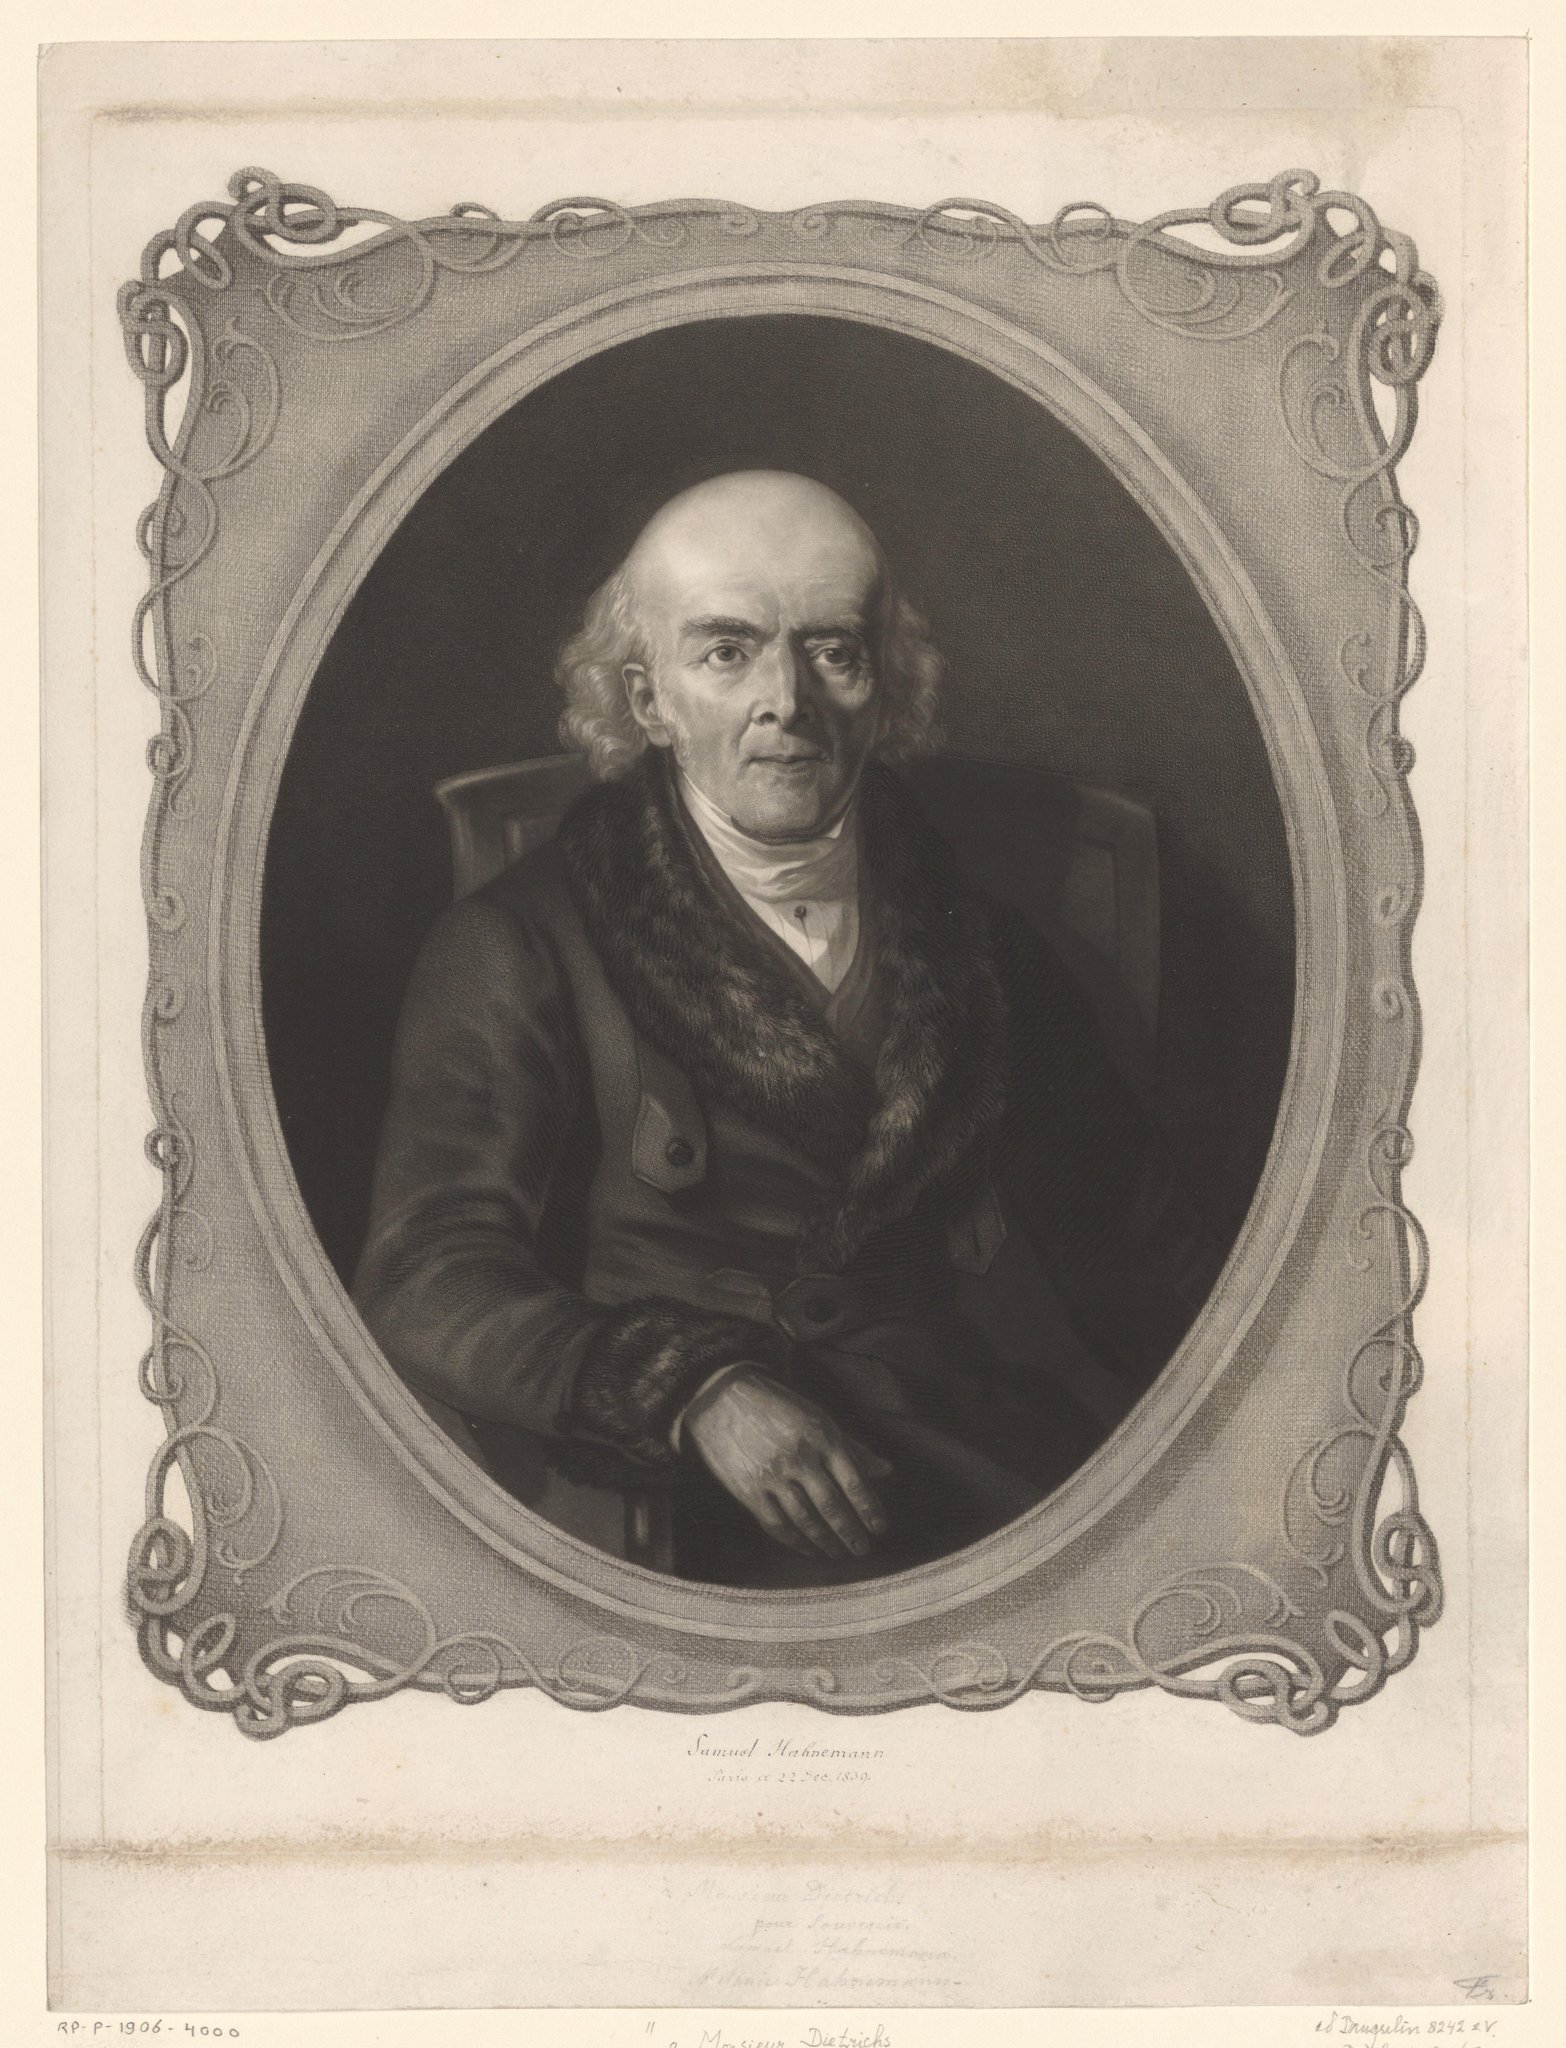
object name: print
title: Samuel Hahnemann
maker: Anonymous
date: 1839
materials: paper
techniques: aquatint, etching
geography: paris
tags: paris, historical persons, physician, doctor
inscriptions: collector's mark: Lugt 2228